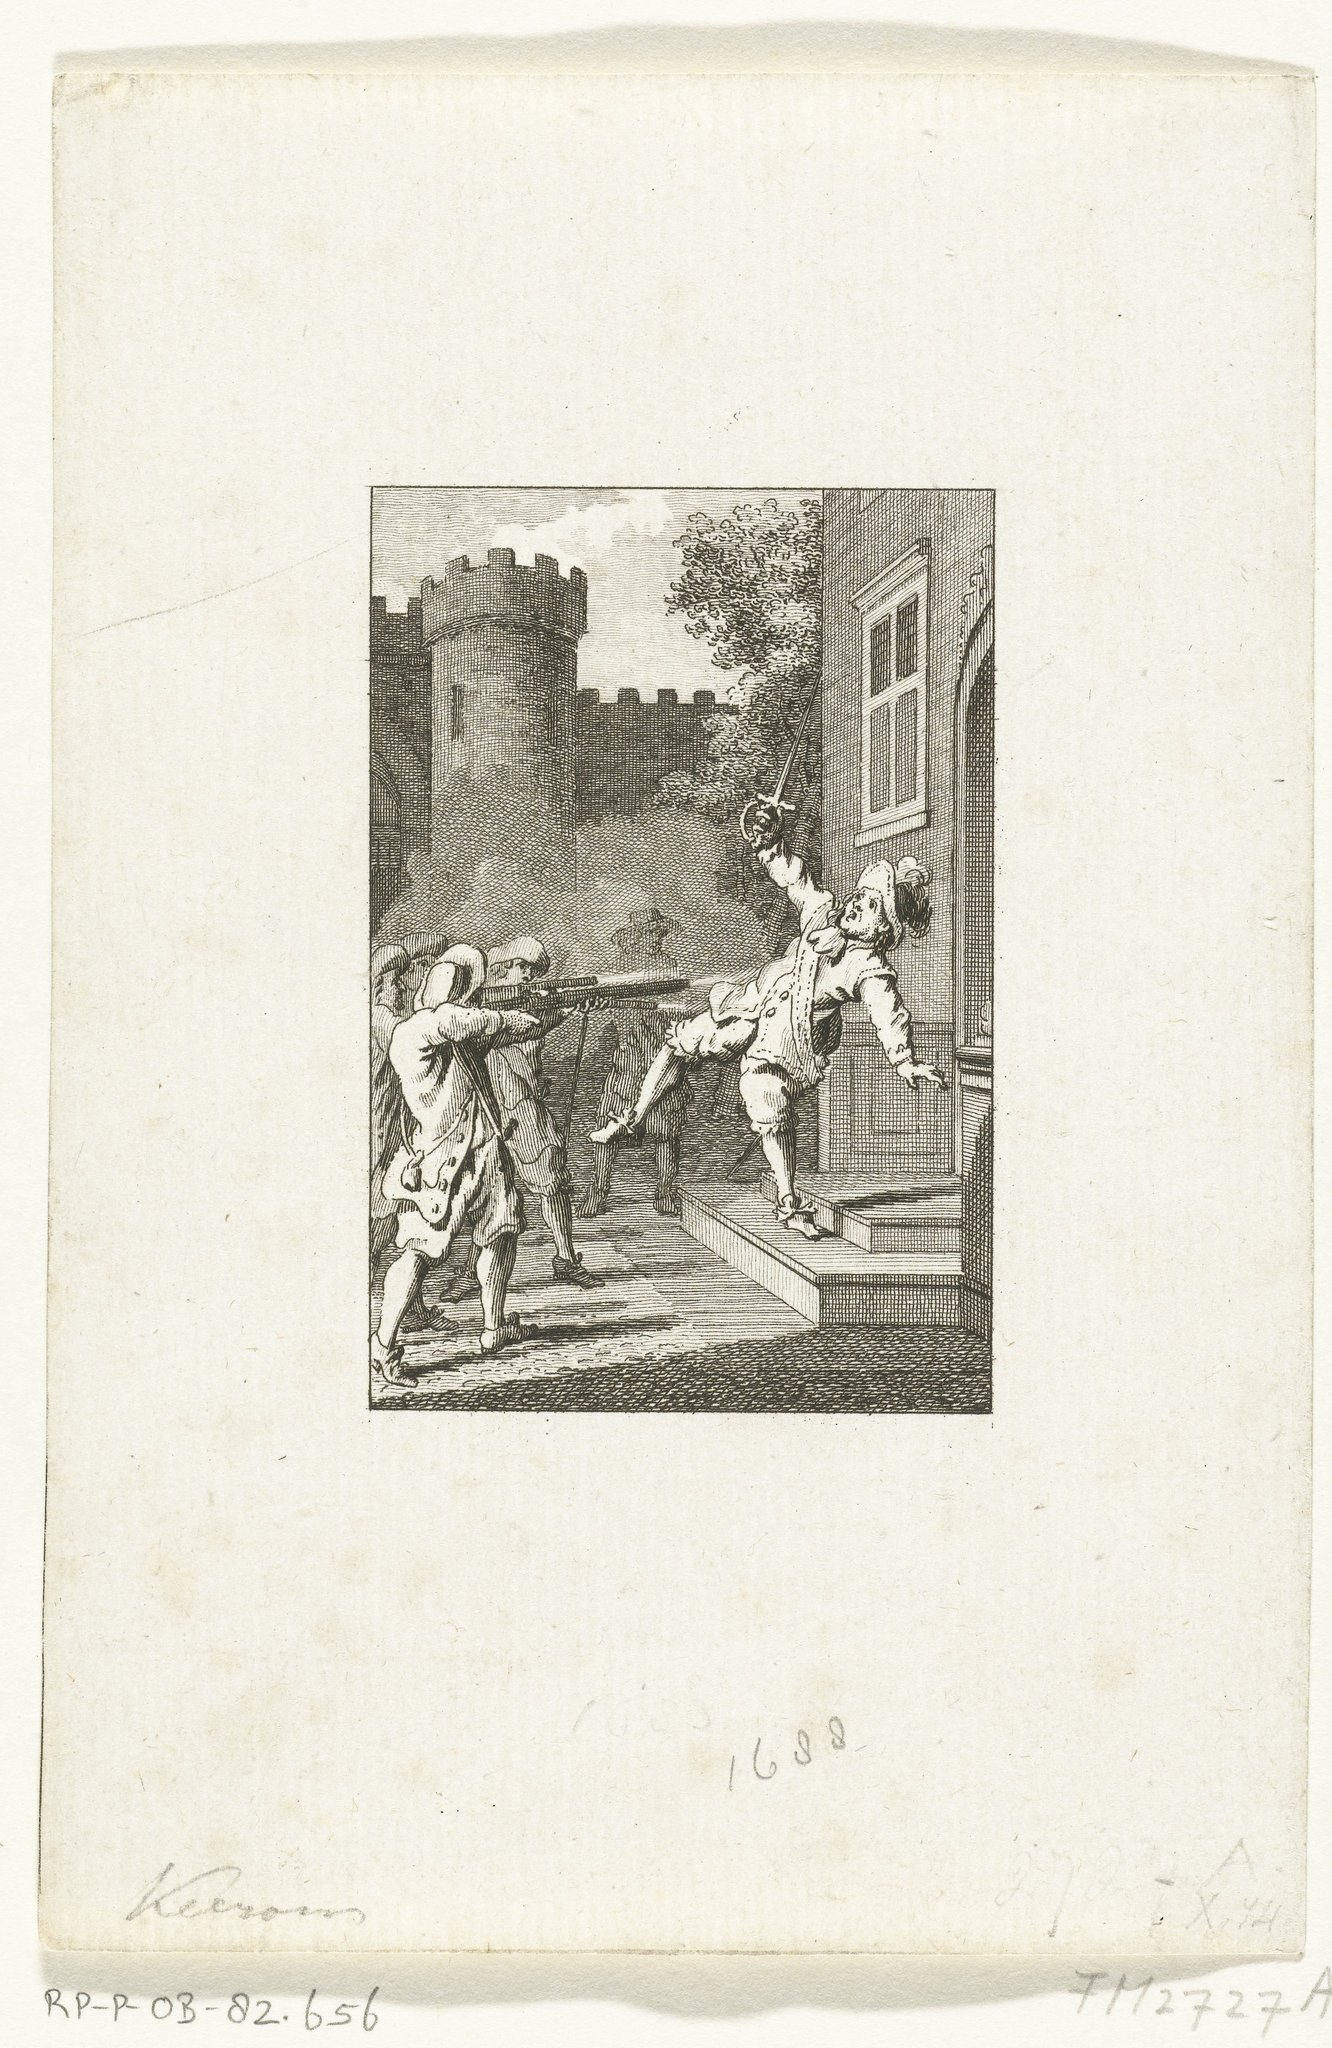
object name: print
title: Moord op Cornelis van Aerssen van Sommelsdijk, 1688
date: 1780-1795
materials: paper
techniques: etching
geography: northern netherlands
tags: murder, violent death, being killed; being mishandled and maltreated; seeking death, suriname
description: Gebruikt als illustratie in: J. Fokke, Geschiedenissen der Vereenigde Nederlanden voor de vaderlandsche jeugd, Johannes Allart, Amsterdam 1783-1795, 25 delen, dl. X, pl. VI. Dit nummer is een door het RPK toegevoegd nummer en staat niet in Frederik Muller, het werk waar de prent voor is gemaakt of uit afkomstig is, staat wel vermeld in Frederik Muller.